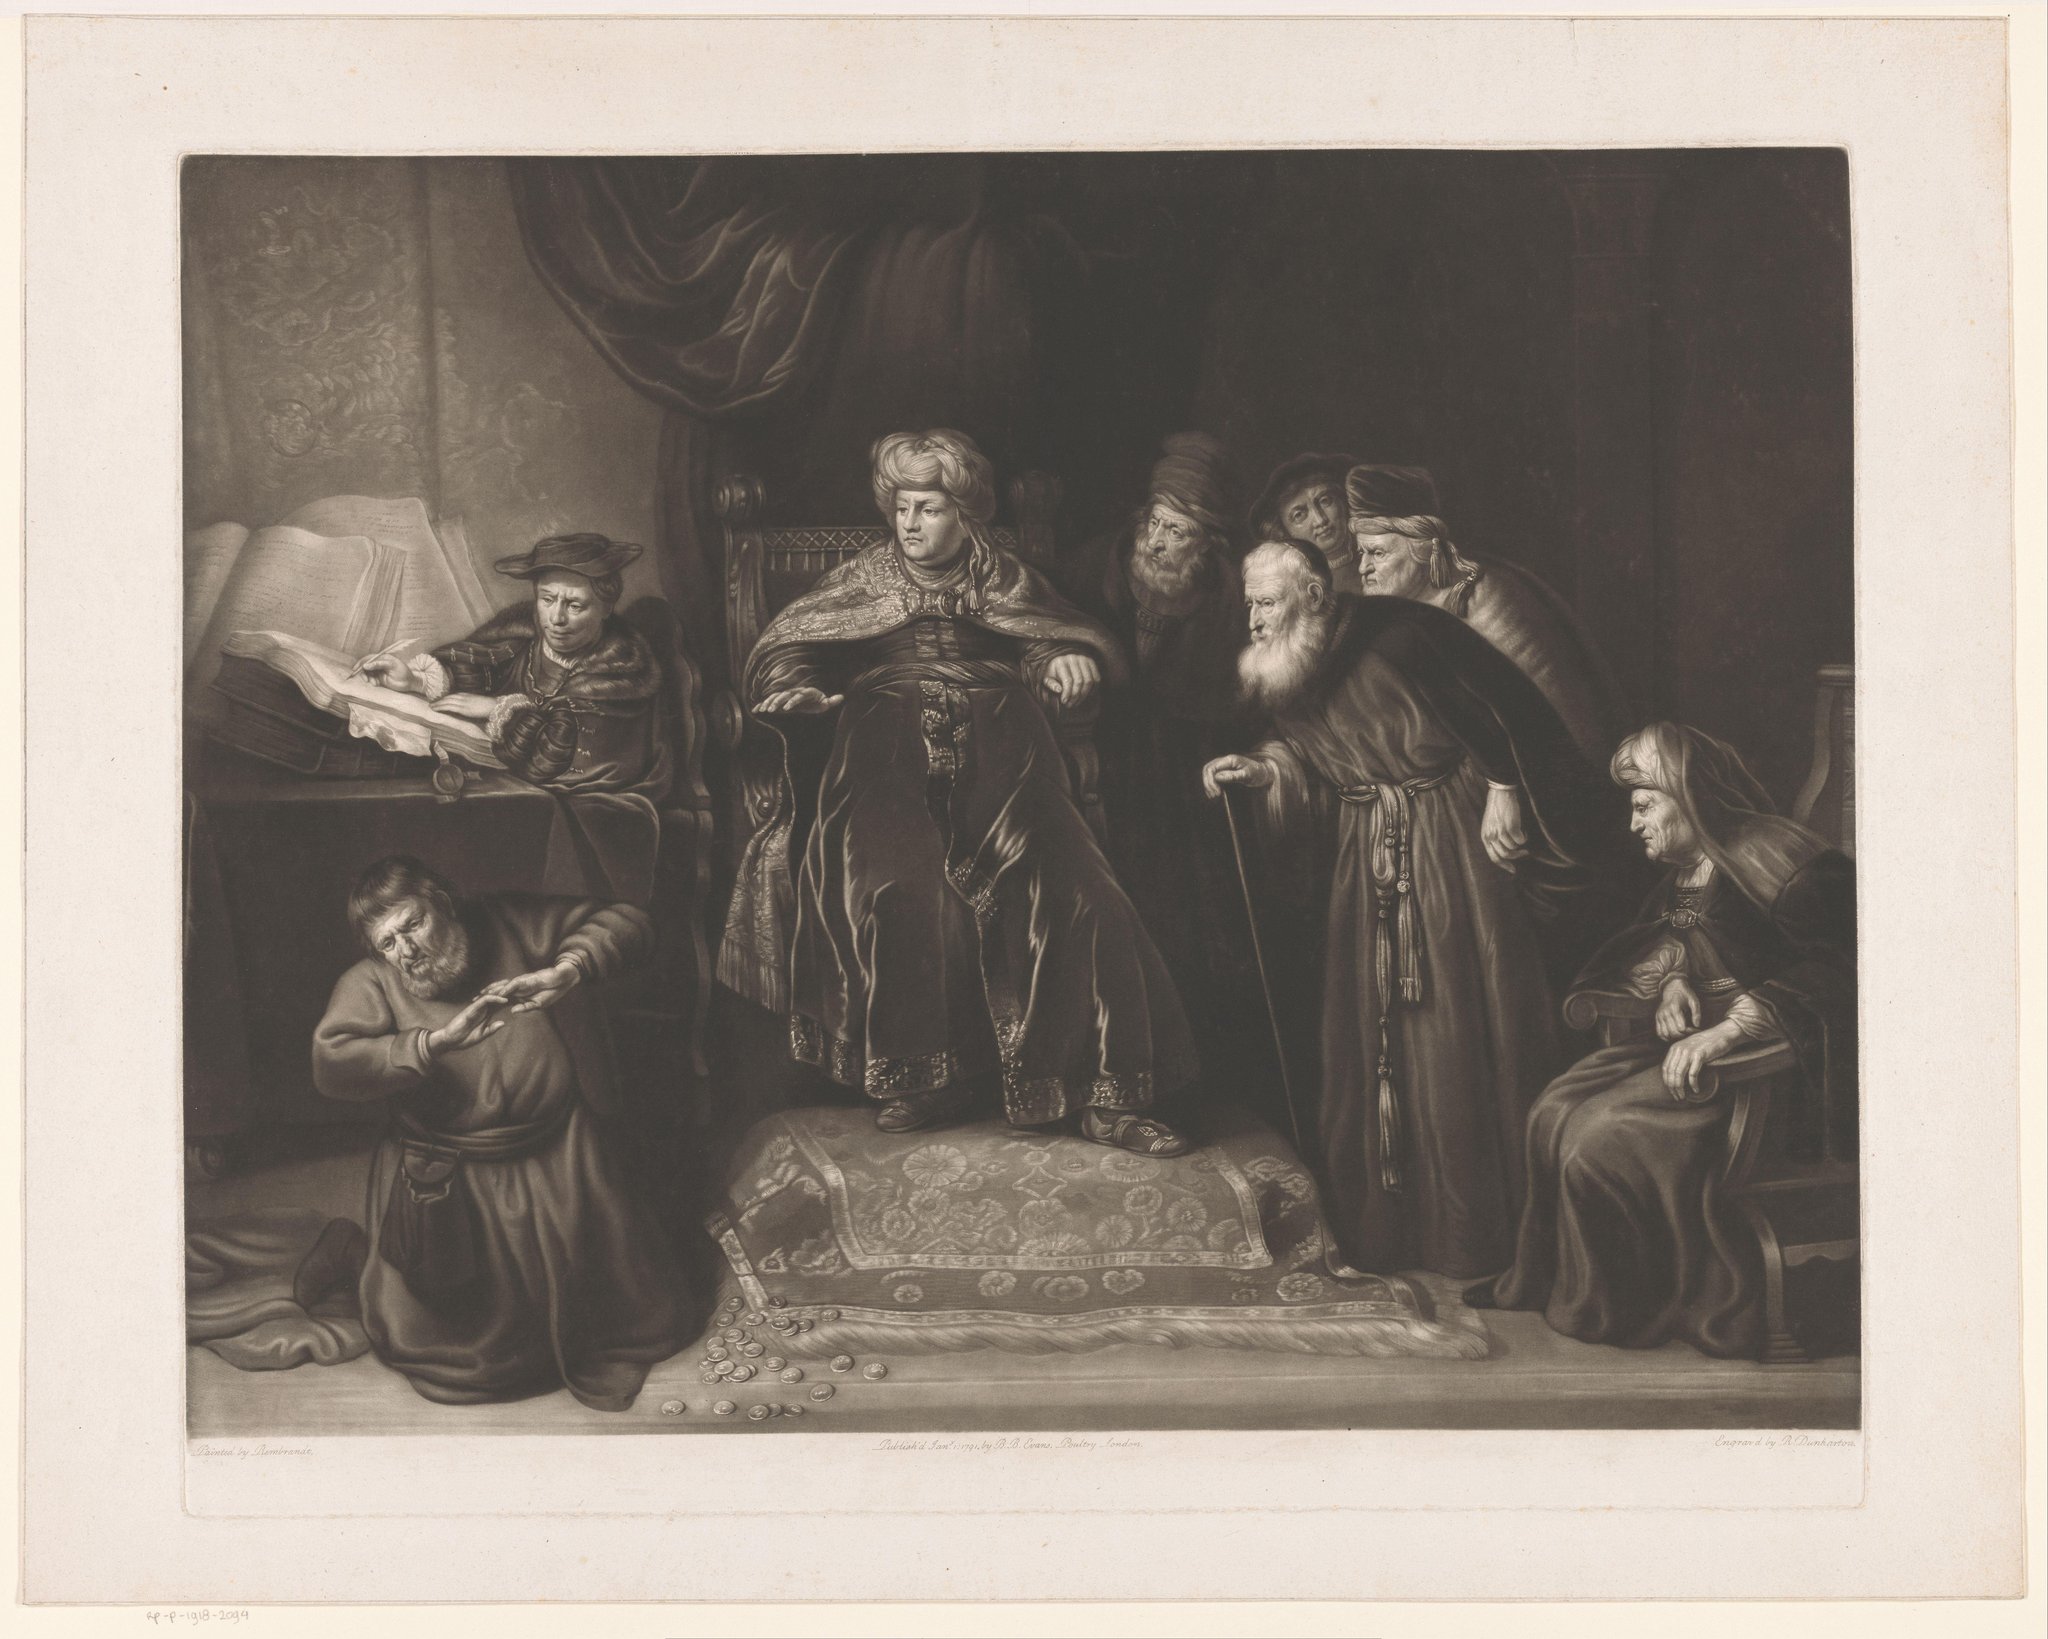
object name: print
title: Judas brengt de zilverlingen terug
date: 1701-1791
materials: paper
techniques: mezzotint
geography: london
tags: judas before the sanhedrin returning the pieces of silver; he throws the money to the ground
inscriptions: collector's mark: Lugt 2233